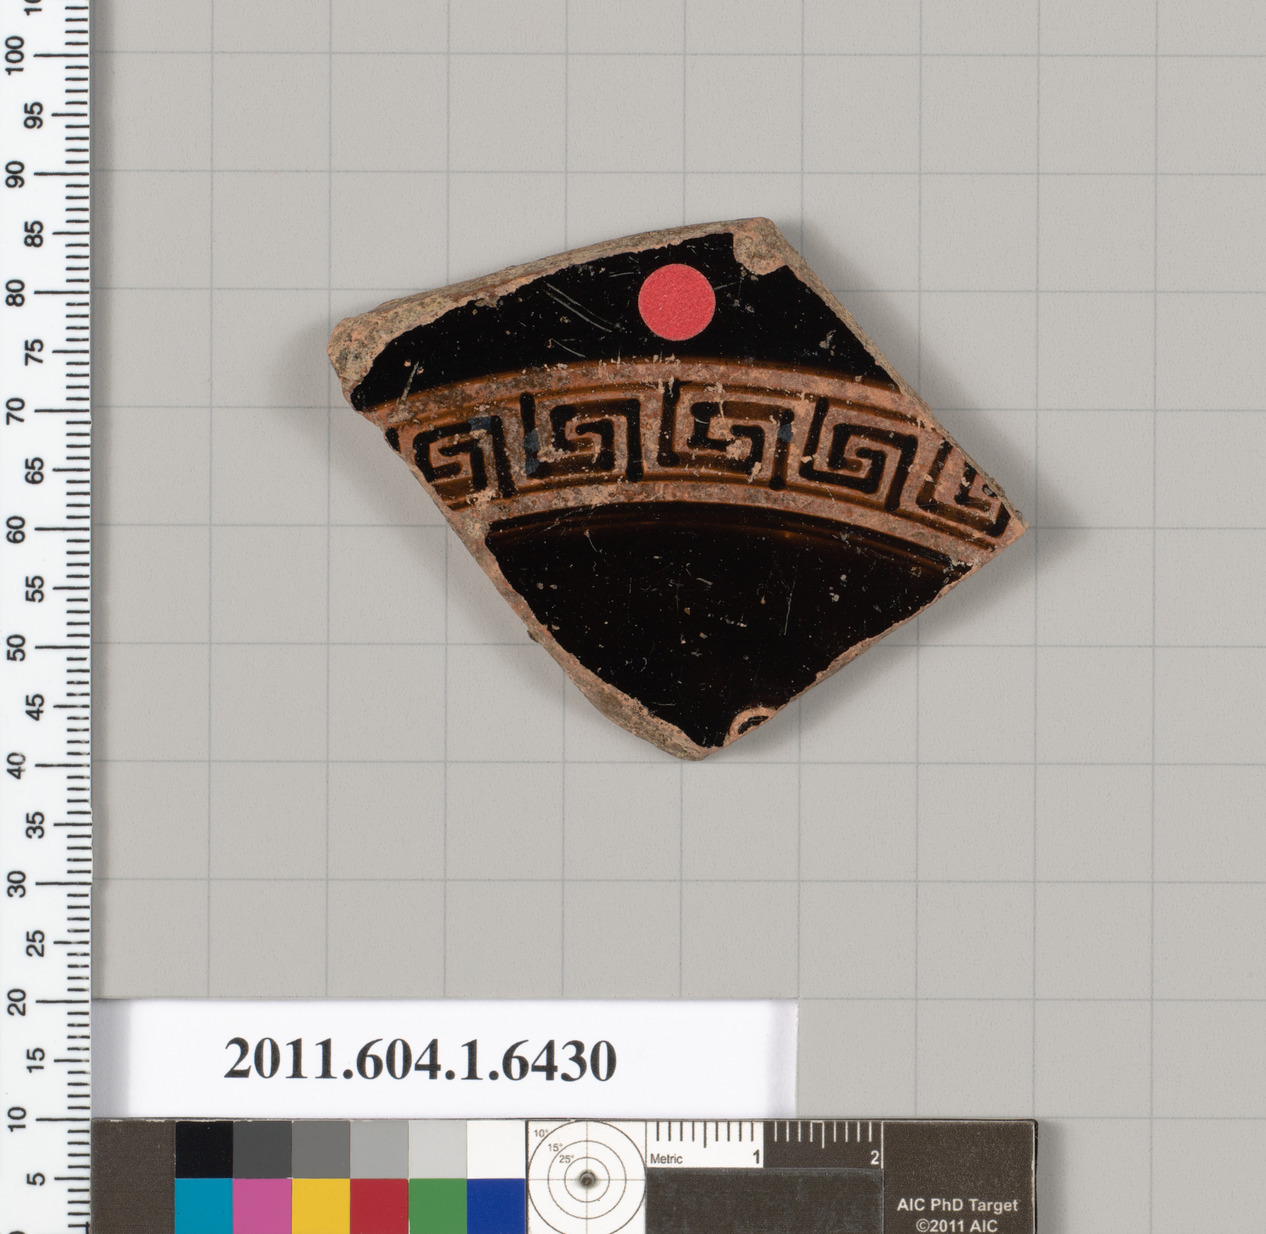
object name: kylix fragment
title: Terracotta fragment of a kylix (drinking cup)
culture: greek, attic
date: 490-480 BCE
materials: terracotta